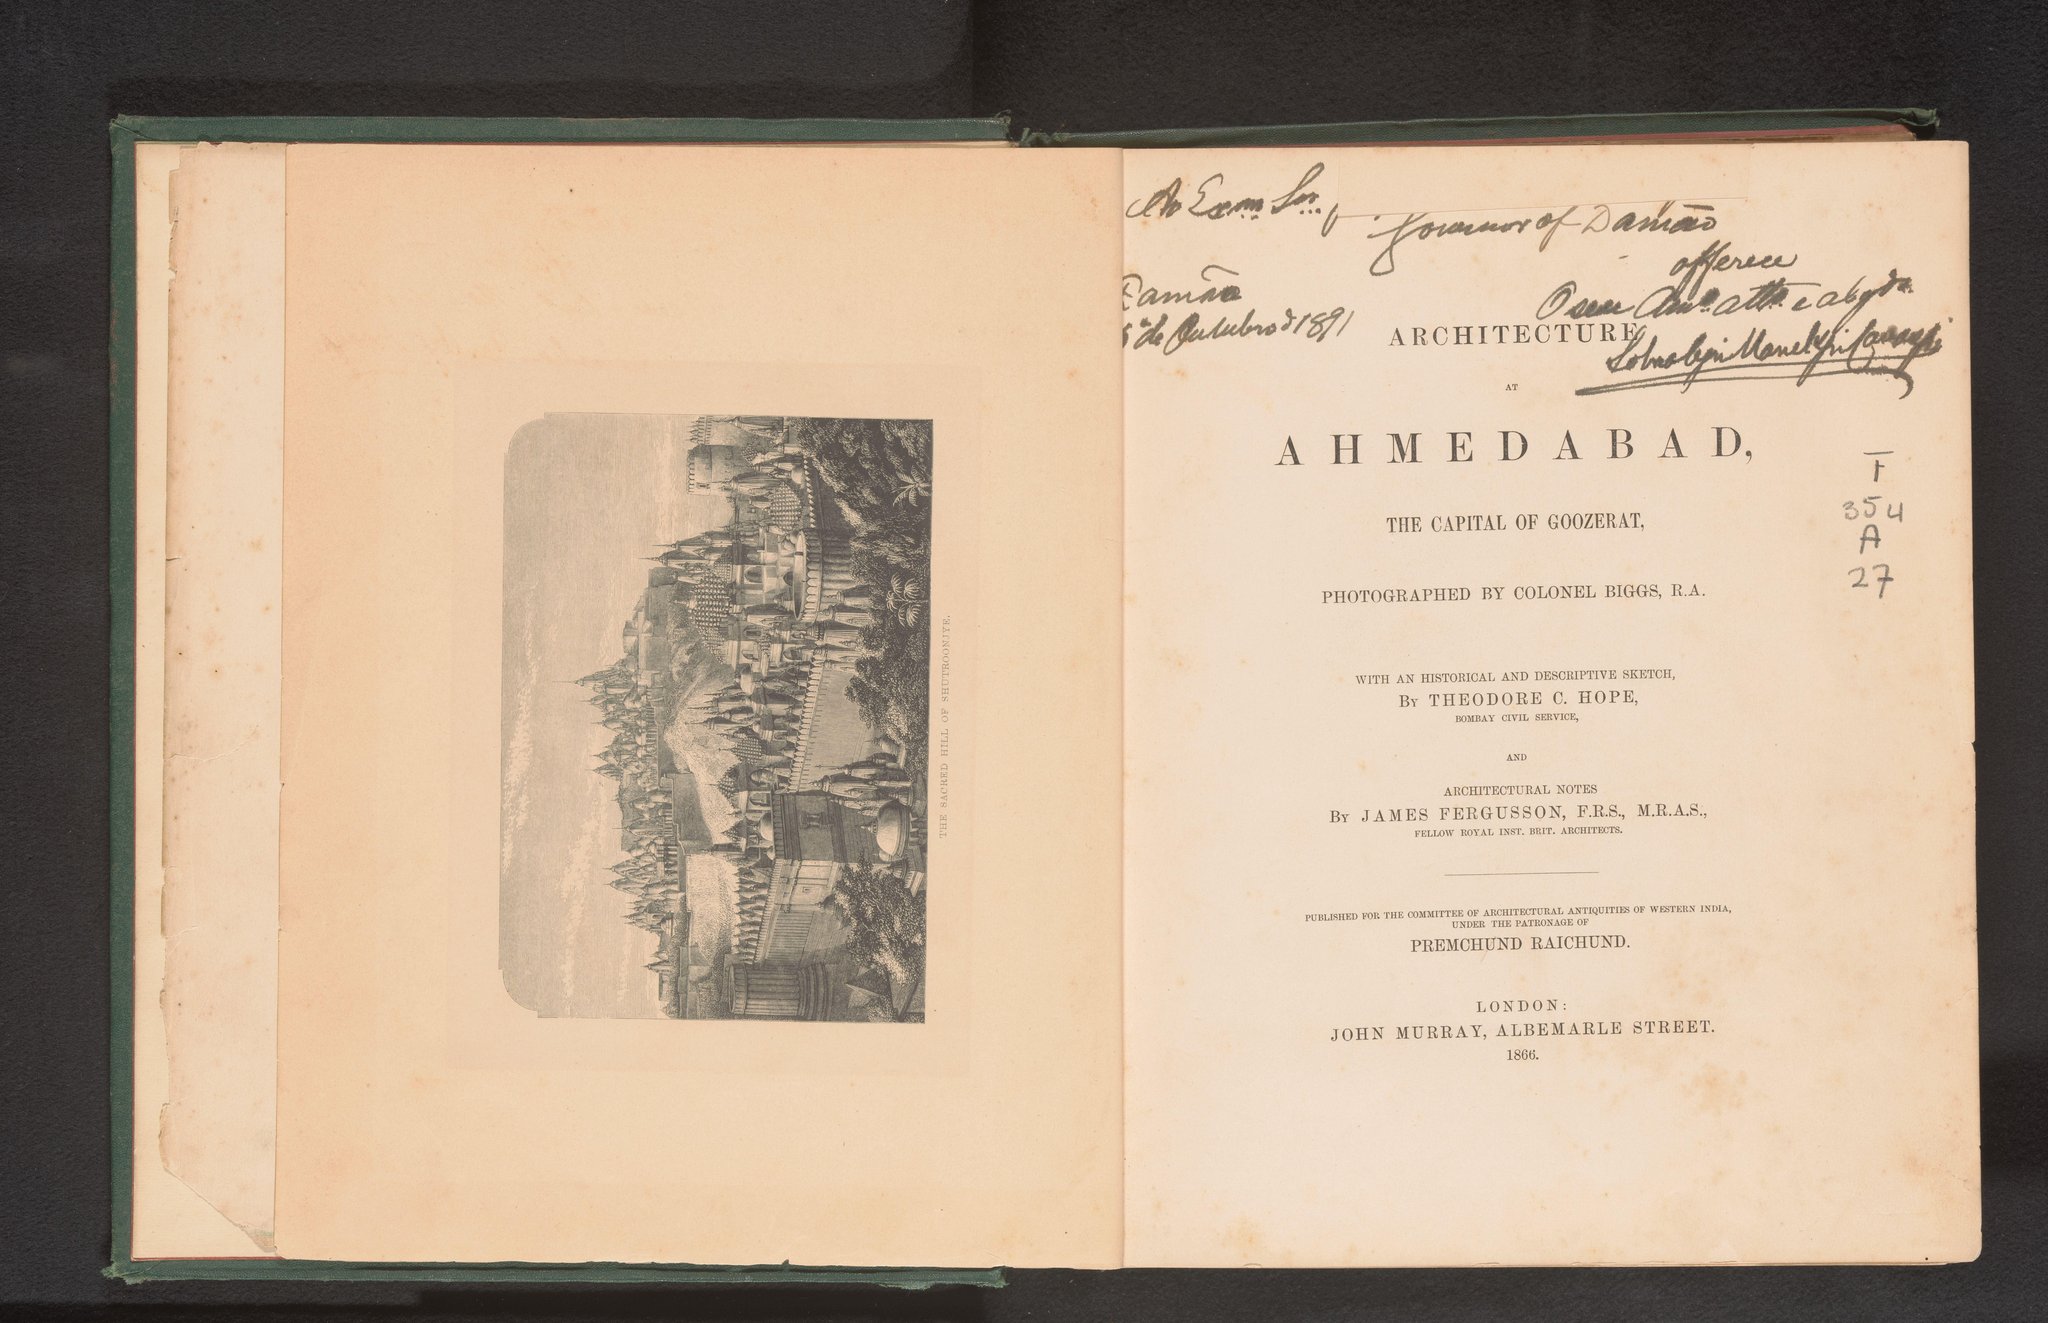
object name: book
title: Architecture of Ahmedabad, the capital of Goozerat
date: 1866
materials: linen, paper, photographic support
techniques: albumen print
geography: london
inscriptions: name: ‘Bound by Edmonds&Remnants. London’, name: ‘Lyvraria Bertrand S.A.R.L’